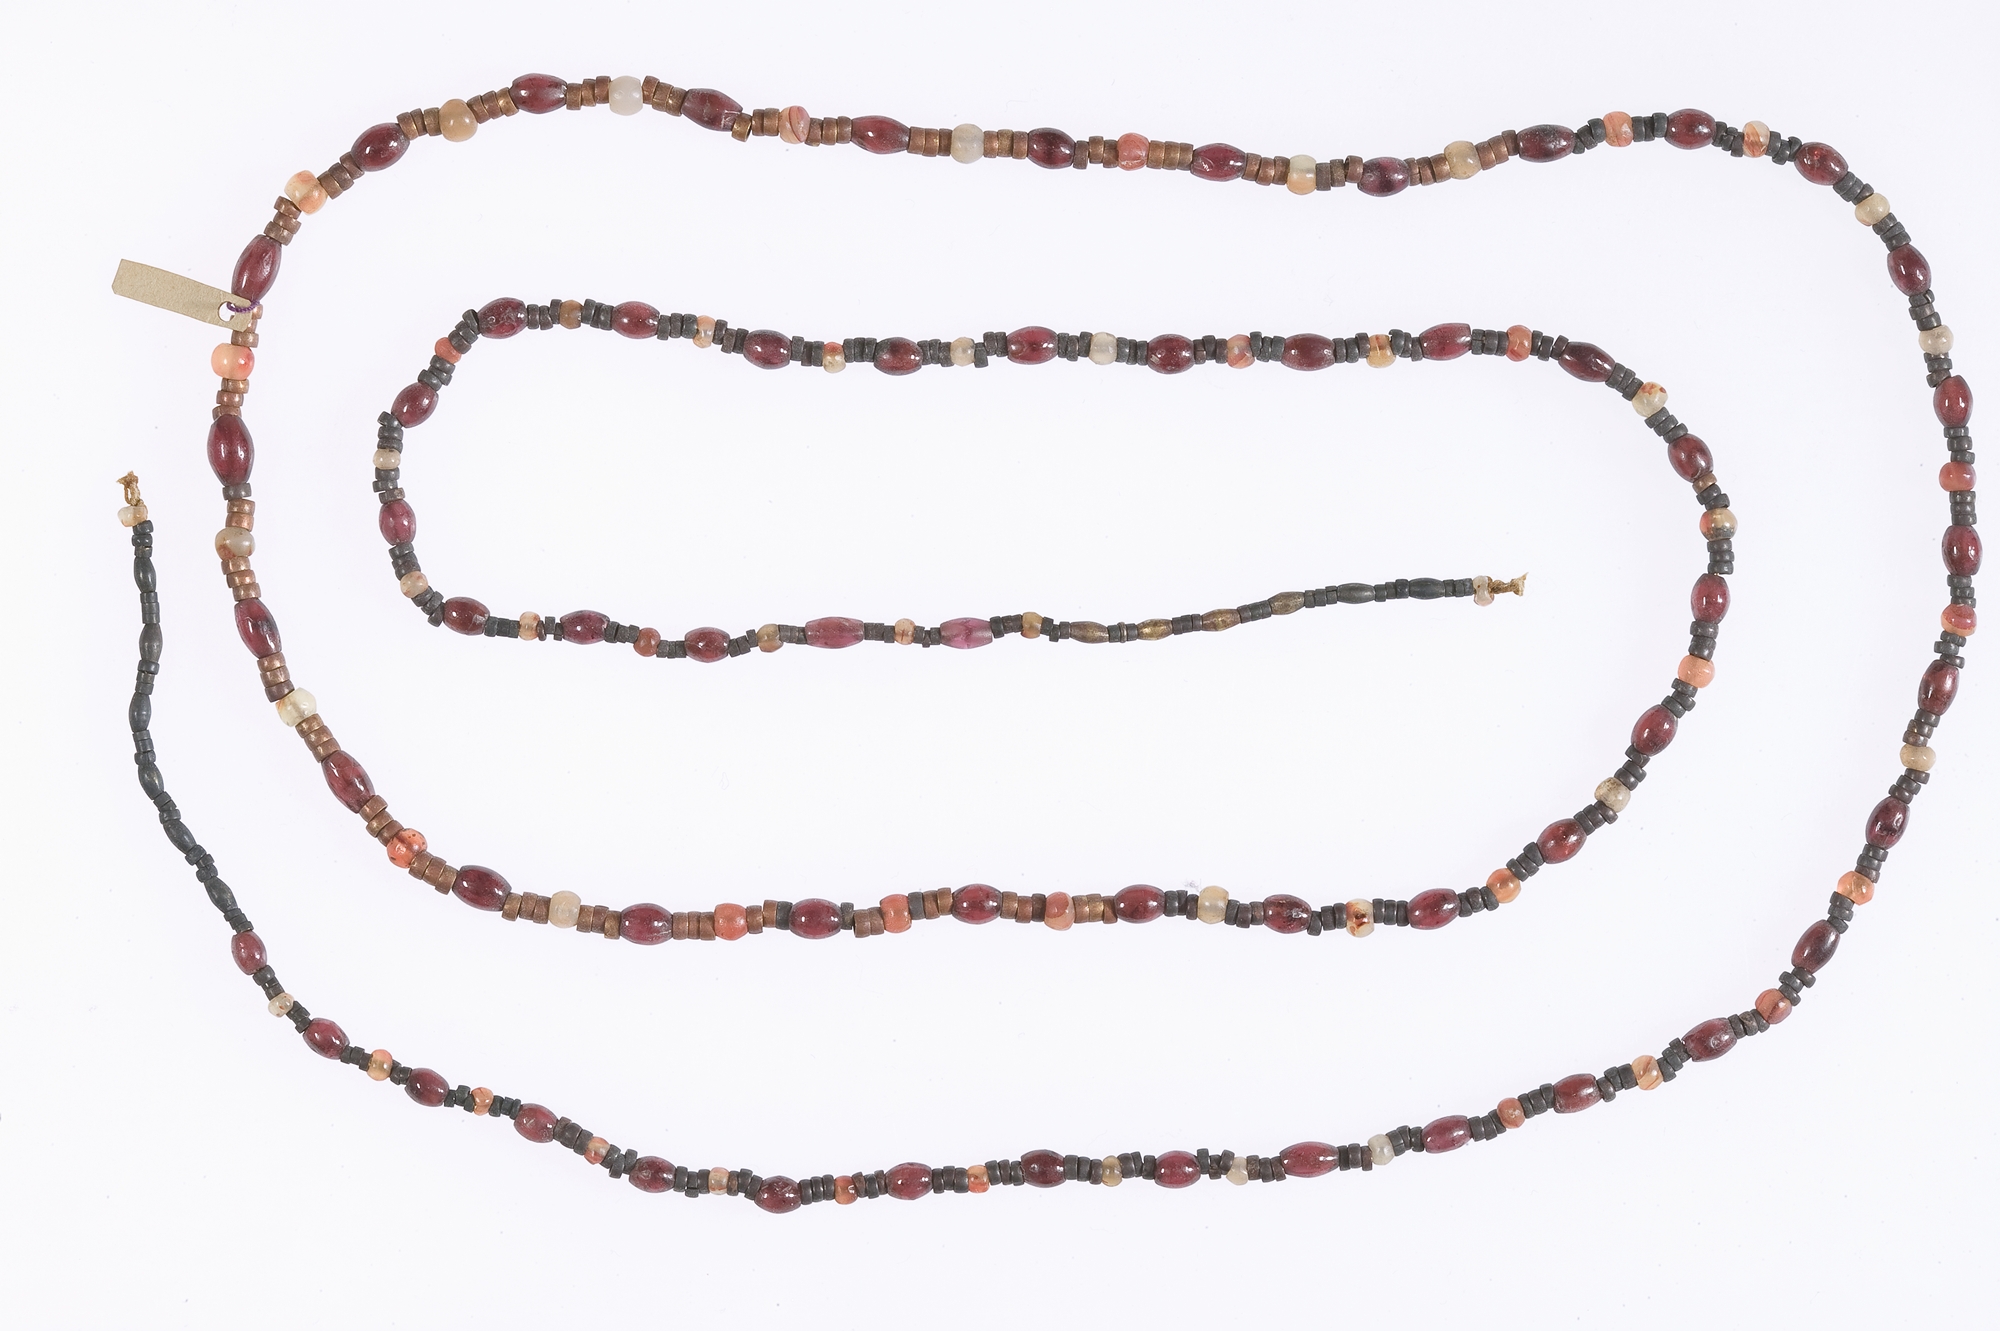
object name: necklace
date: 1991-1450 BCE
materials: gemstone, gold, silver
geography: egypt